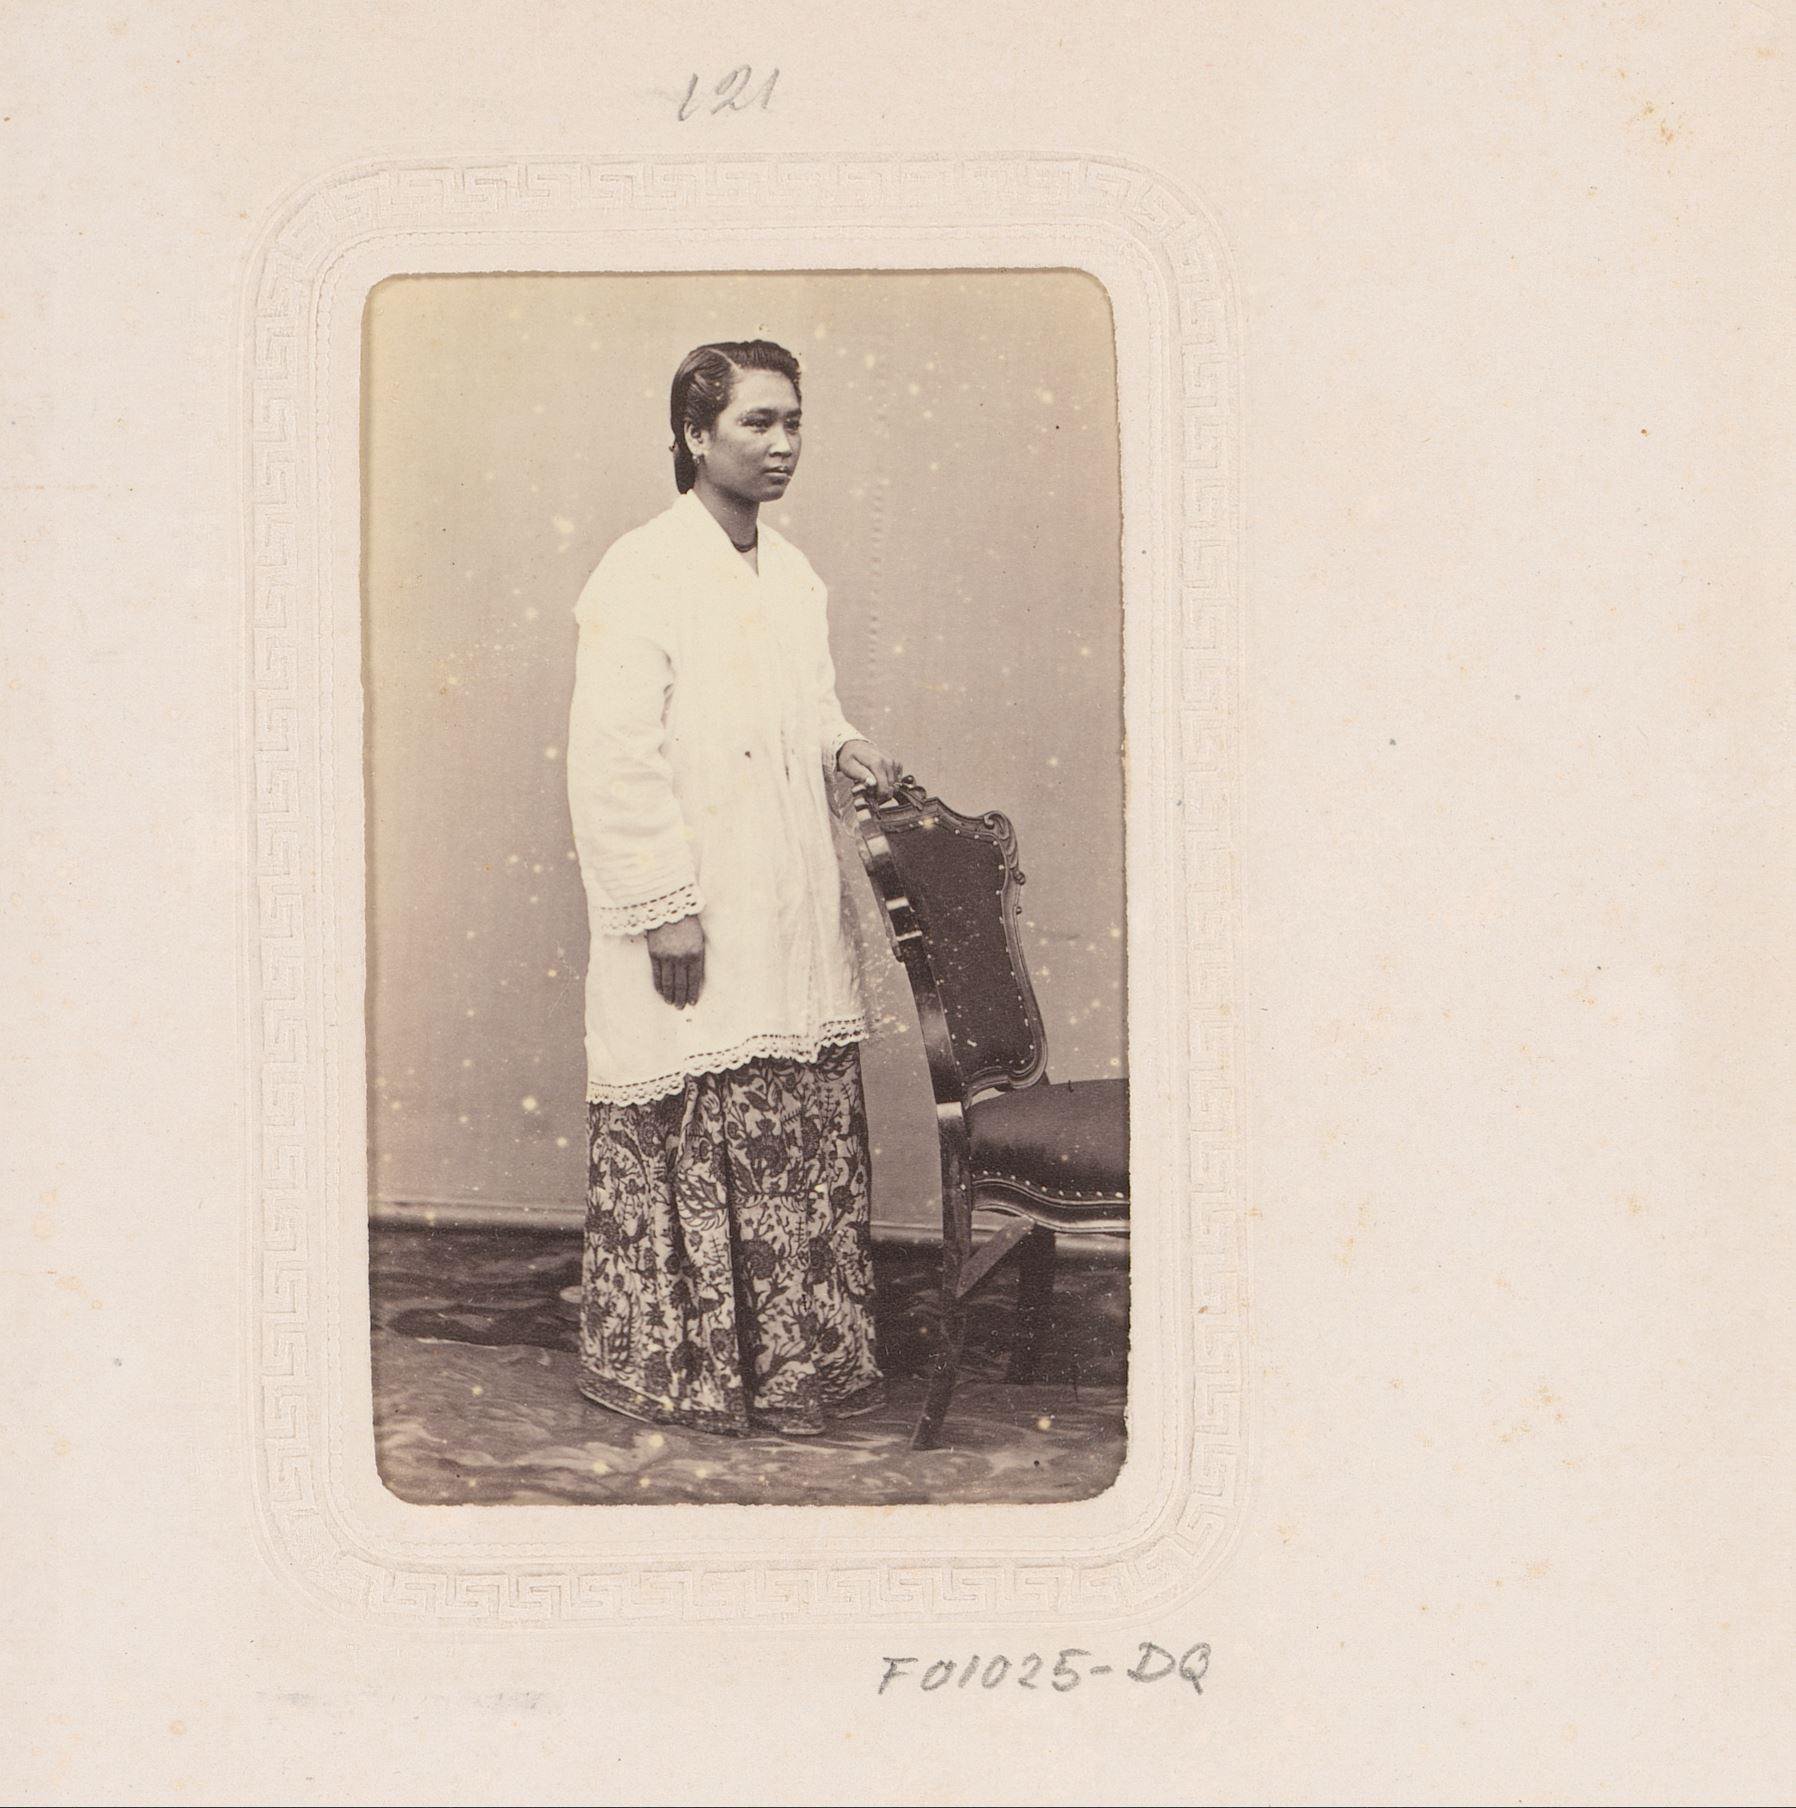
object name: album leaf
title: Portret van een staande Indonesische vrouw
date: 1857-1880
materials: cardboard, photographic support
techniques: albumen print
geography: java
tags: historical persons - bb - woman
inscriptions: inscription: ‘Woodbury & Page/ Photographers/ Java’, number: ‘121’